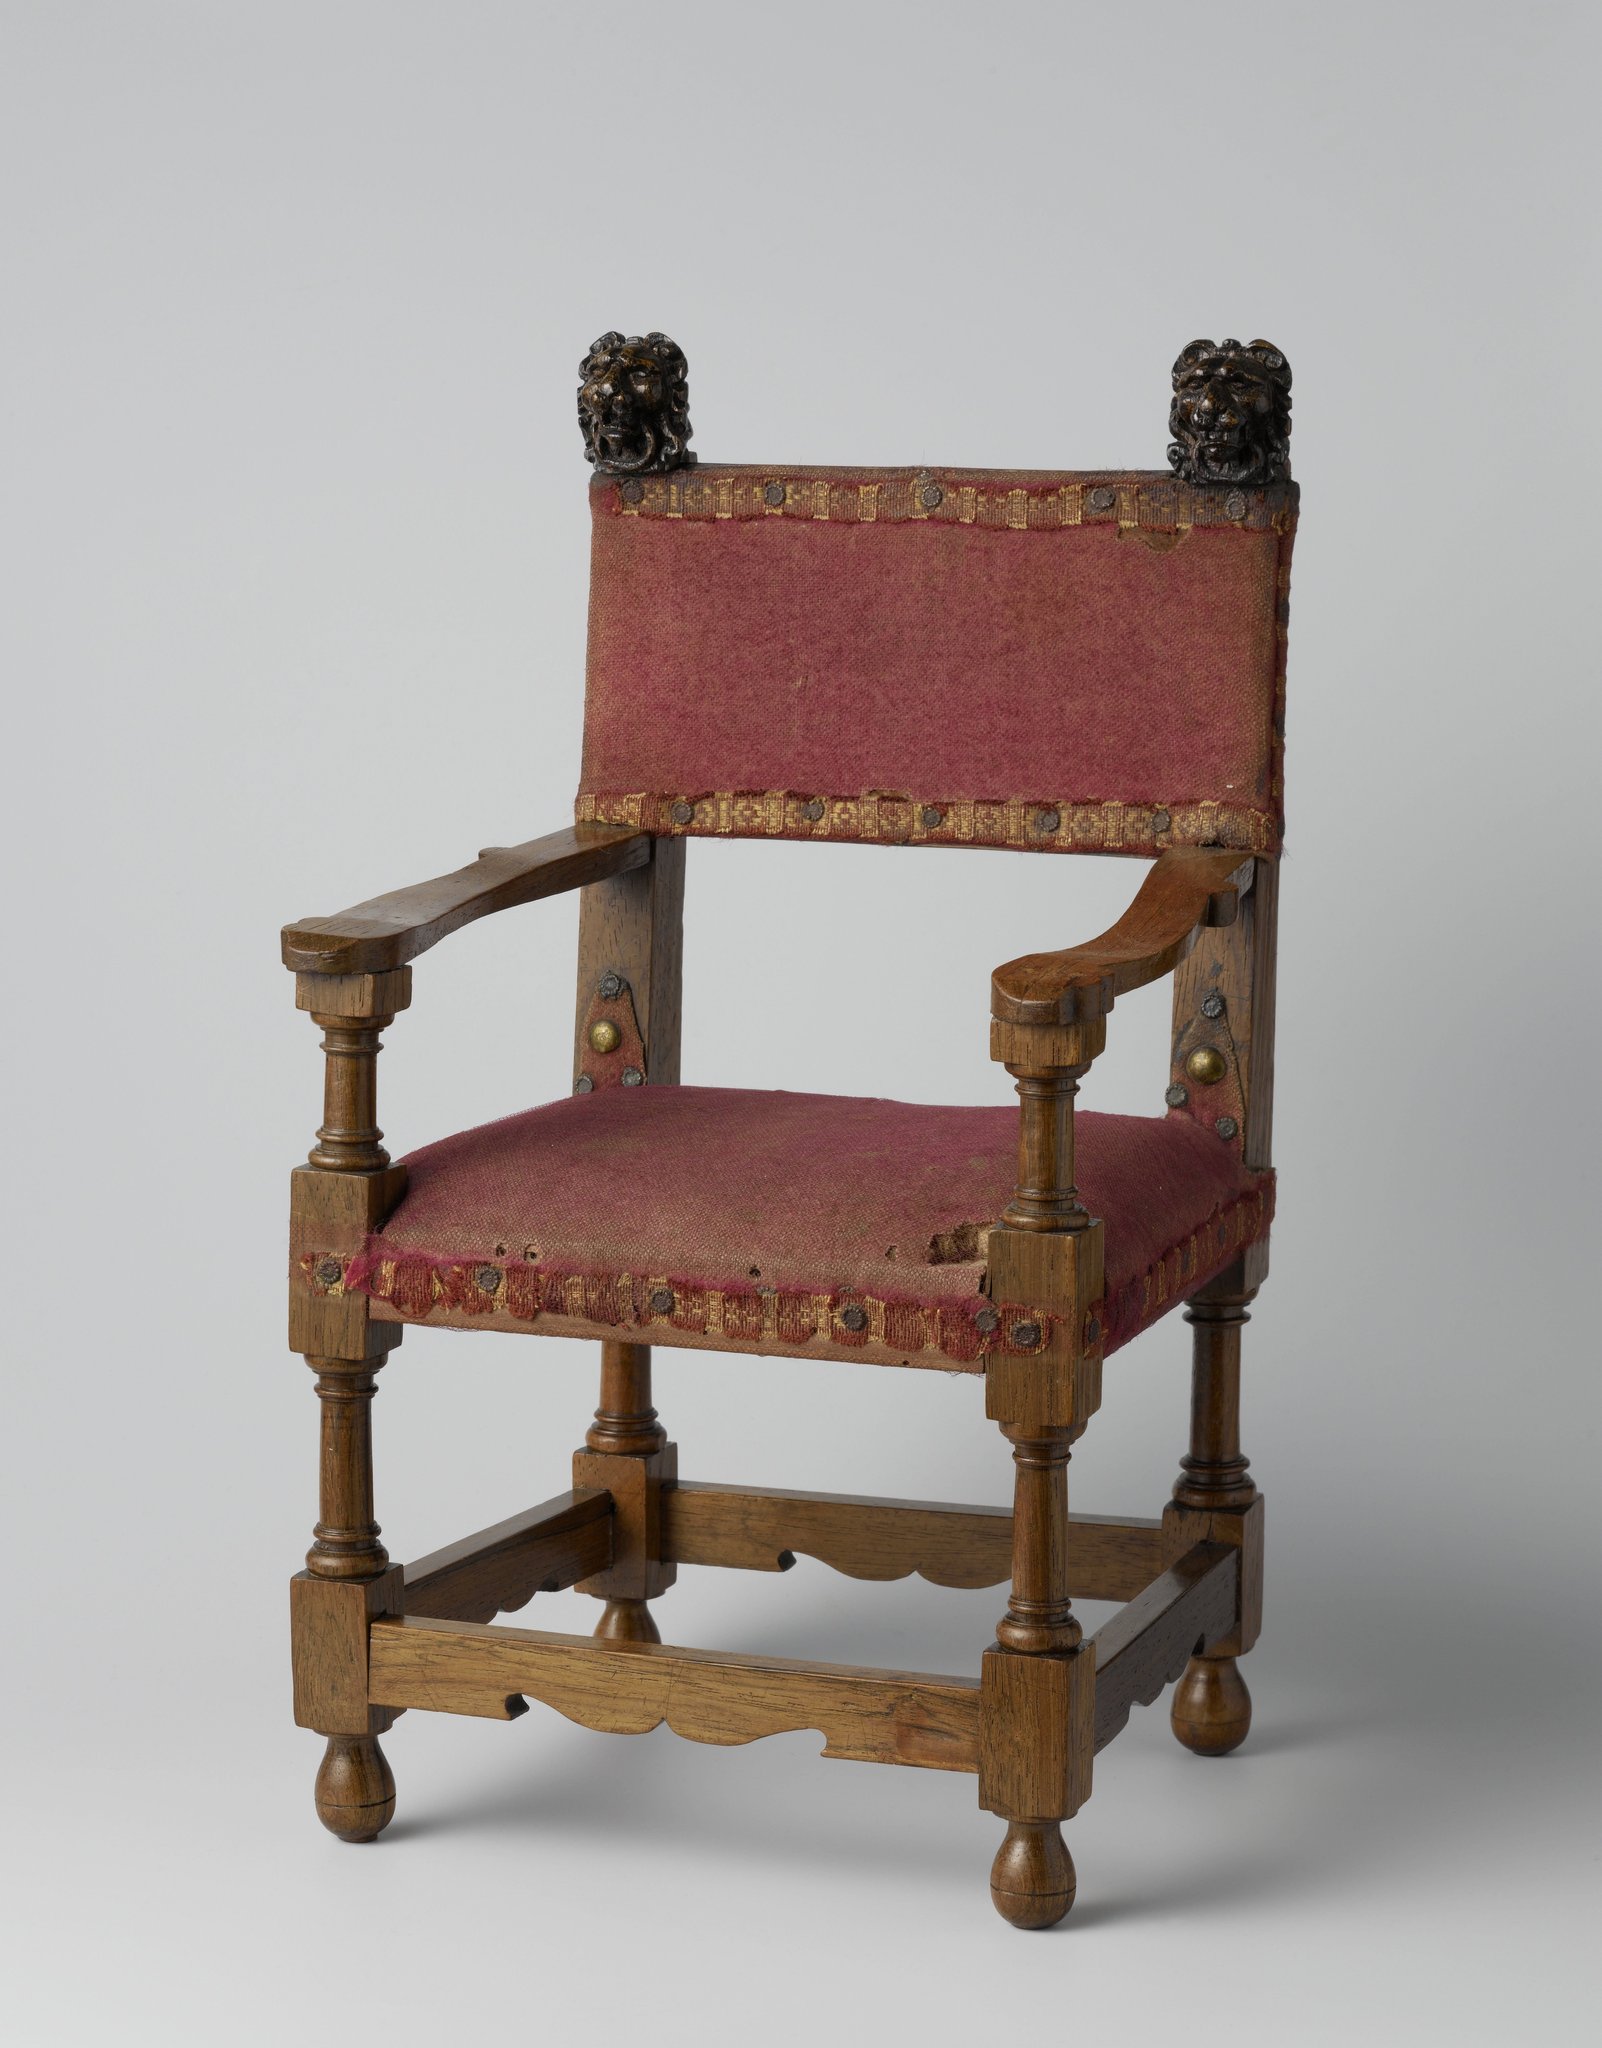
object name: furniture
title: Miniatuur armstoel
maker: Anonymous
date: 1650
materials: textile, wood, silk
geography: northern netherlands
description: Armstoel van palissanderhout, met de oorspronkelijke bekleding van rood laken met een ingeperst patroon, afgezet met een geweven zijden band in rood en geel. De poten met kolomvormige geledingen staan op peervormige ballen. De achterstijlen eindigen in leeuwenkoppen met ringen. De ondersport is accolade-vormig geschulpt.